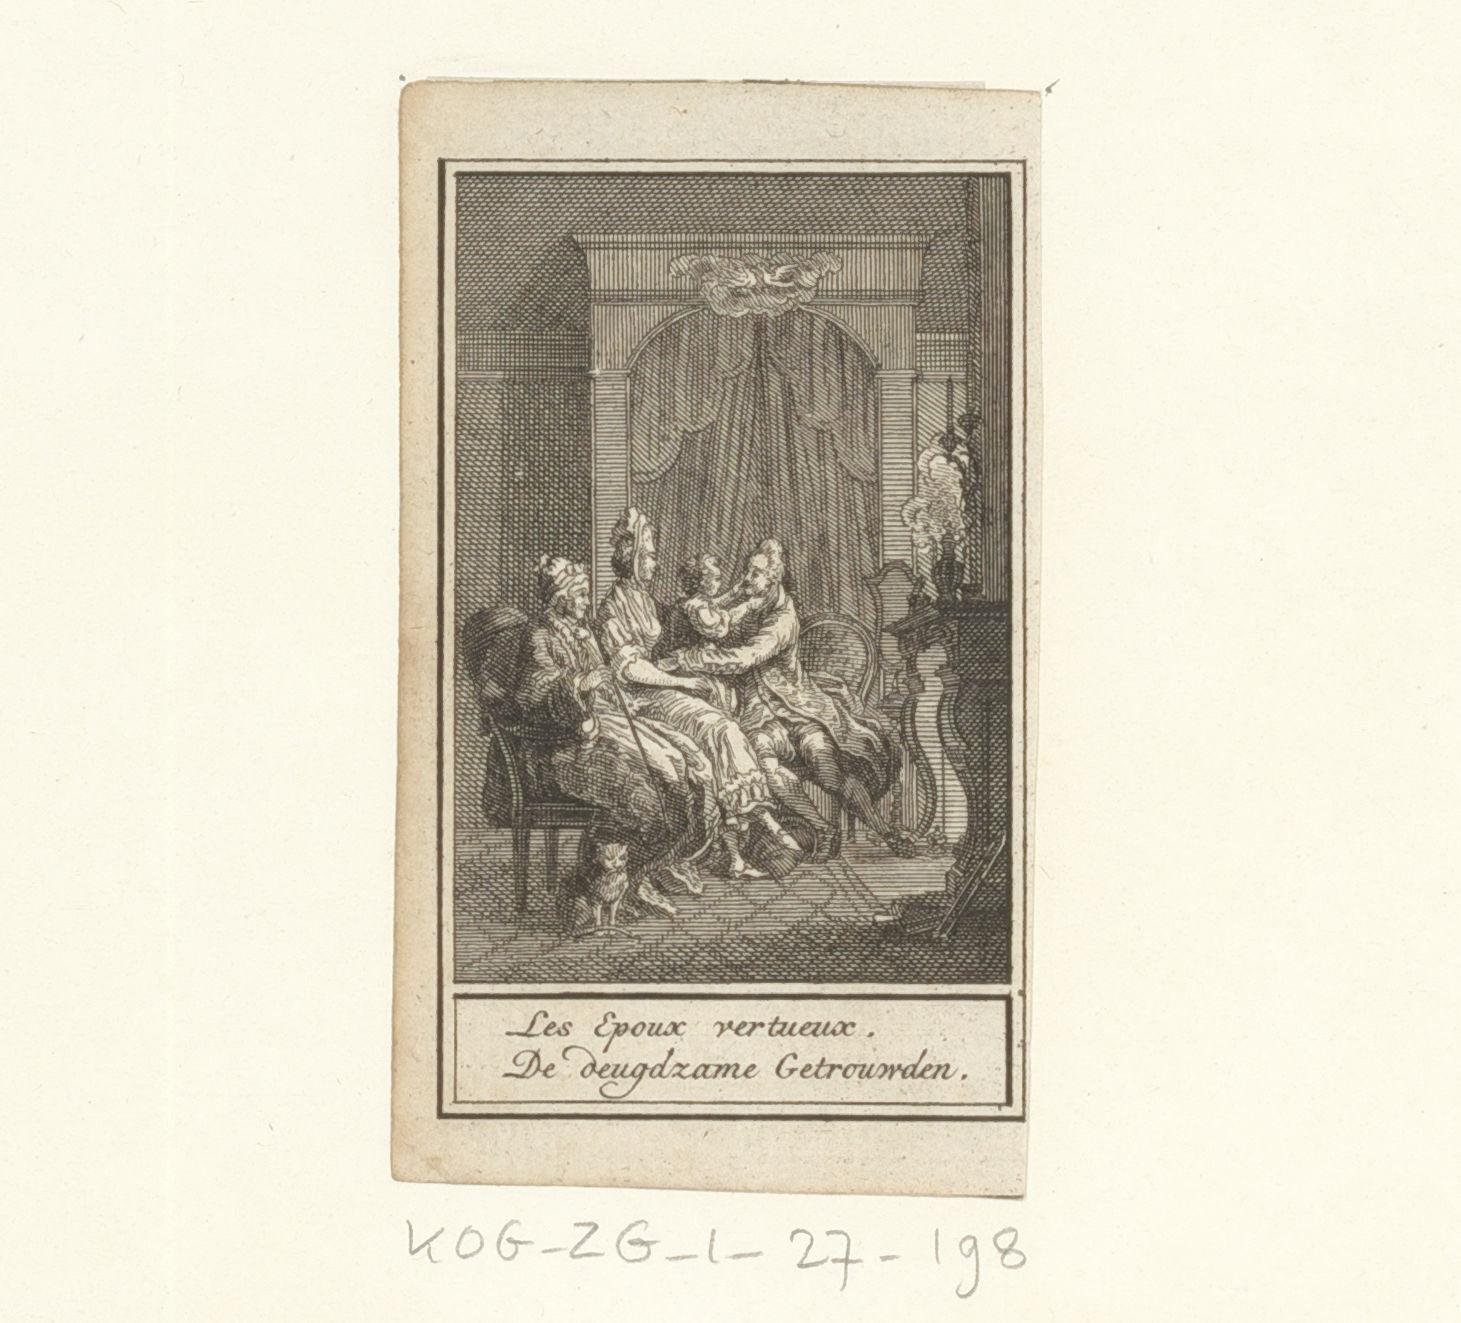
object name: print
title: Les Epoux vertueux / De deugdzame Getrouwden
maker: Anonymous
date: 1725-1799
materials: paper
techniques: etching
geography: netherlands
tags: happy marriage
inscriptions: collector's mark: Lugt 1641, collector's mark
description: Gebruikt als illustratie in een onbekende almanak.